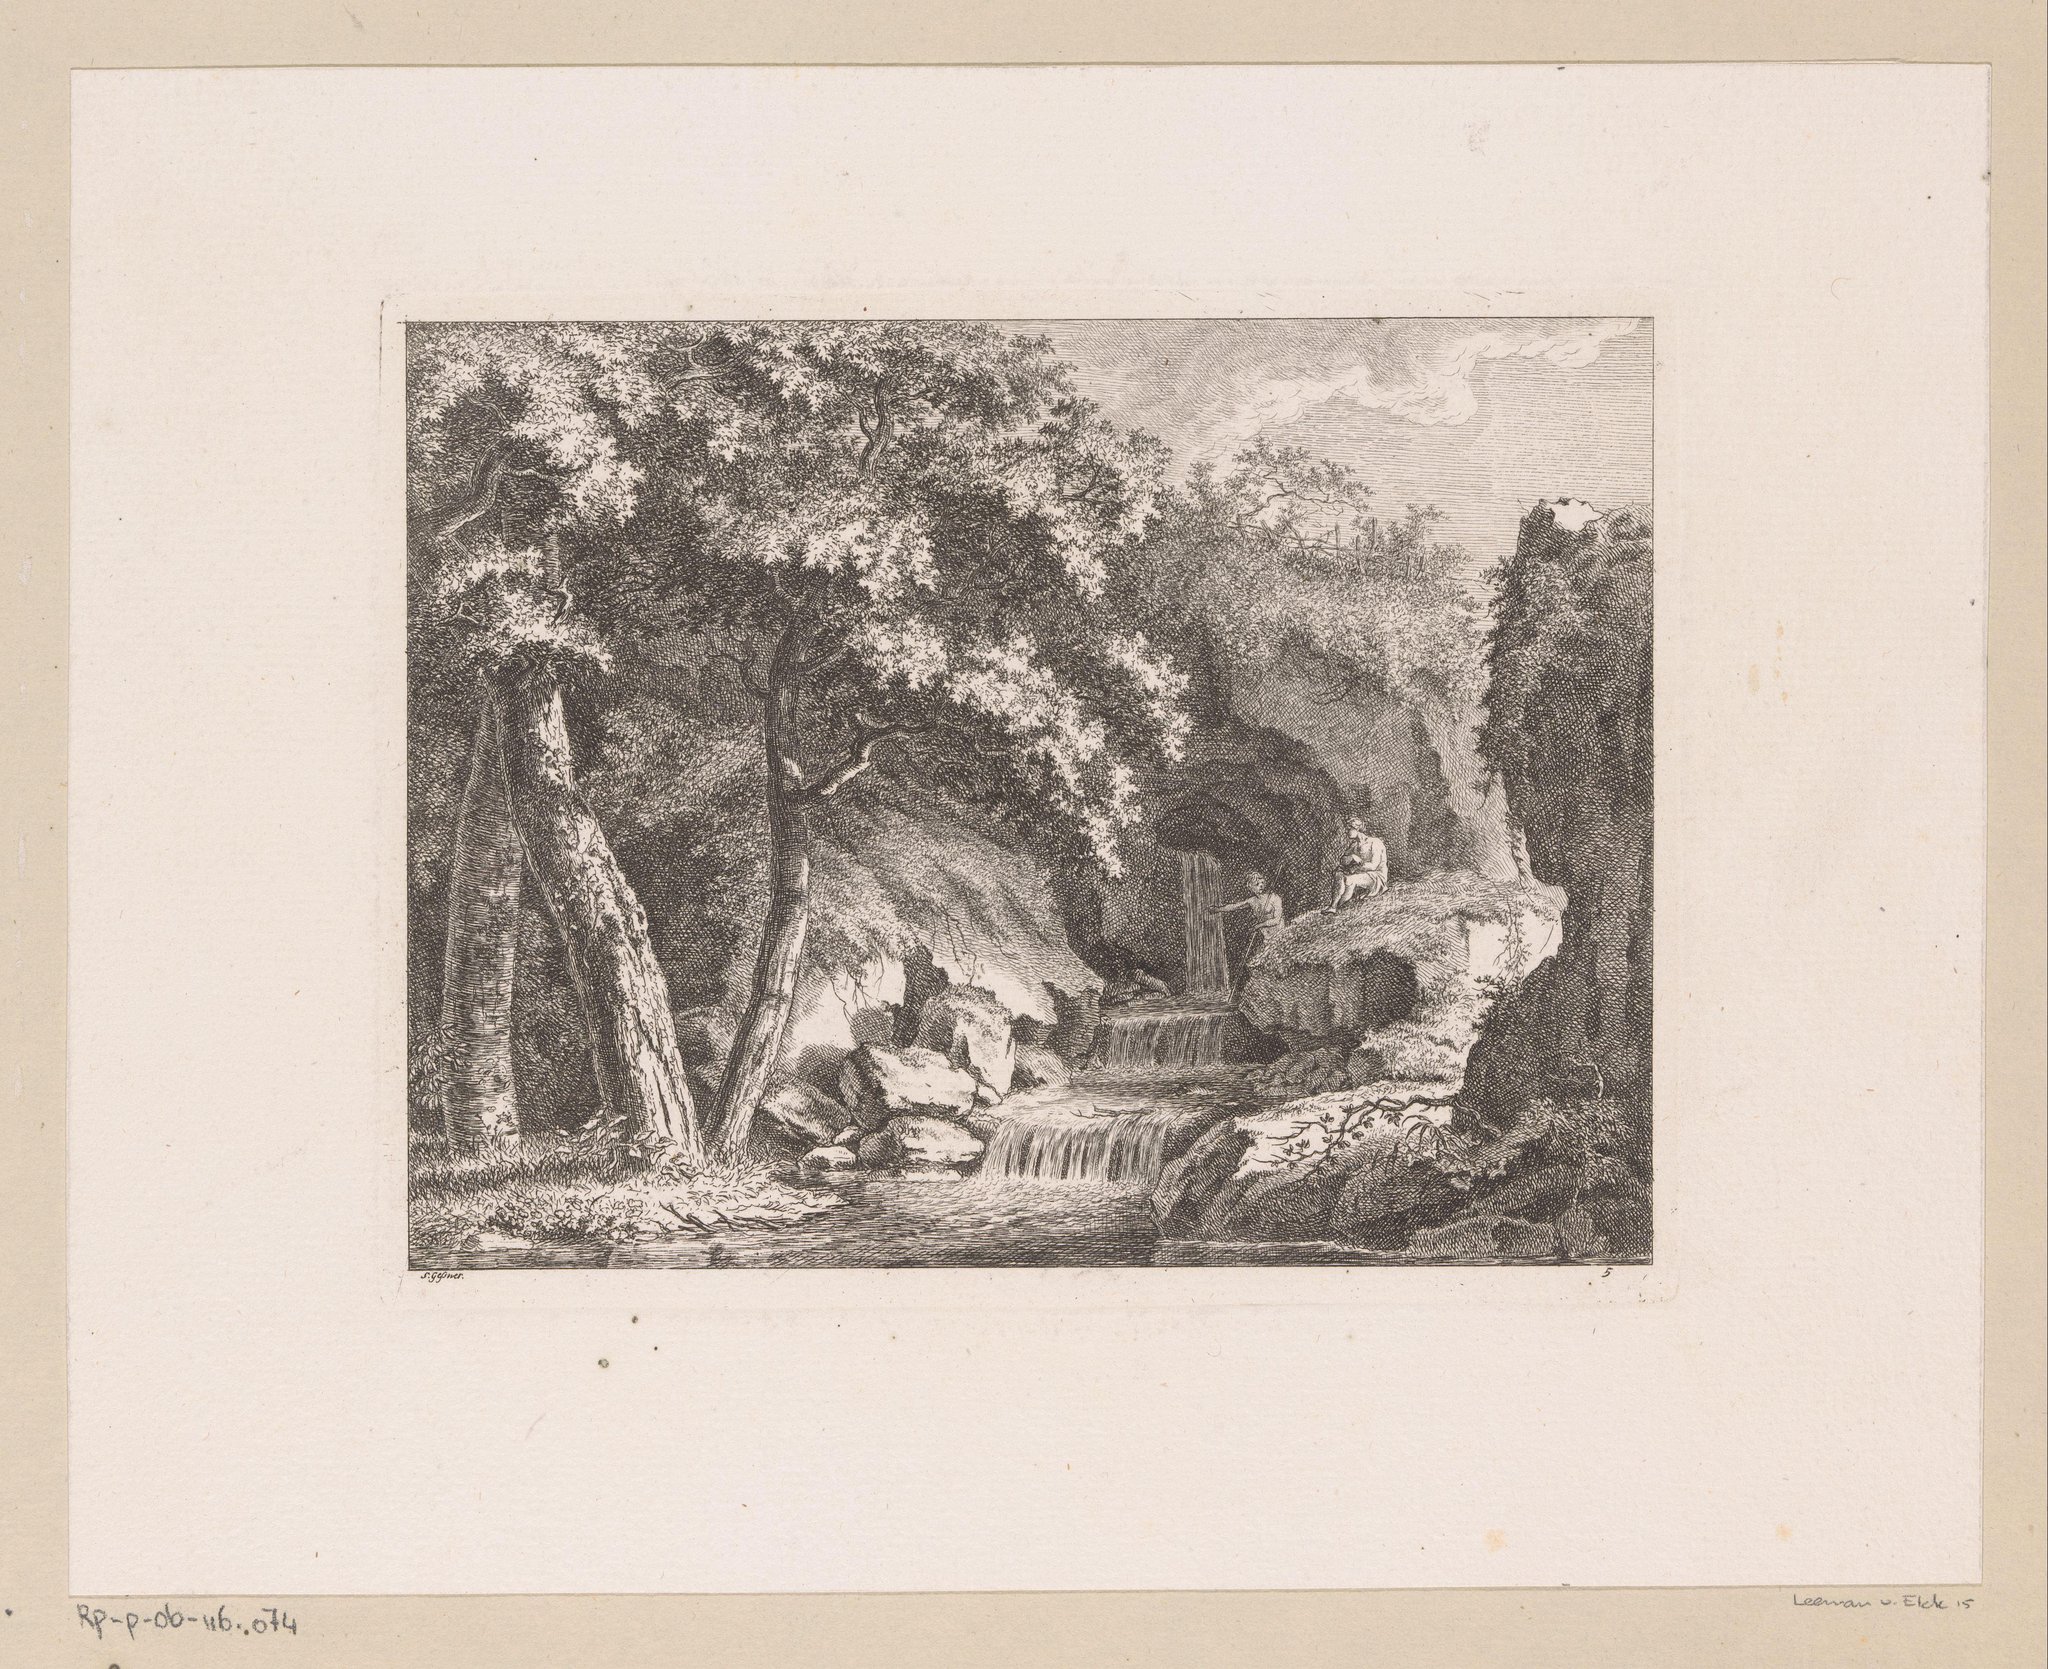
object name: print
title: Arcadische landschappen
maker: salomon gessner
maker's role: painter, print maker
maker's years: 1730-1788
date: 1767-1768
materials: paper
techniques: etching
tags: waterfall - hh - ideal landscapes, herding, herdsman, herdswoman, shepherd, shepherdess, cowherd, etc.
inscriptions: collector's mark: Lugt 240